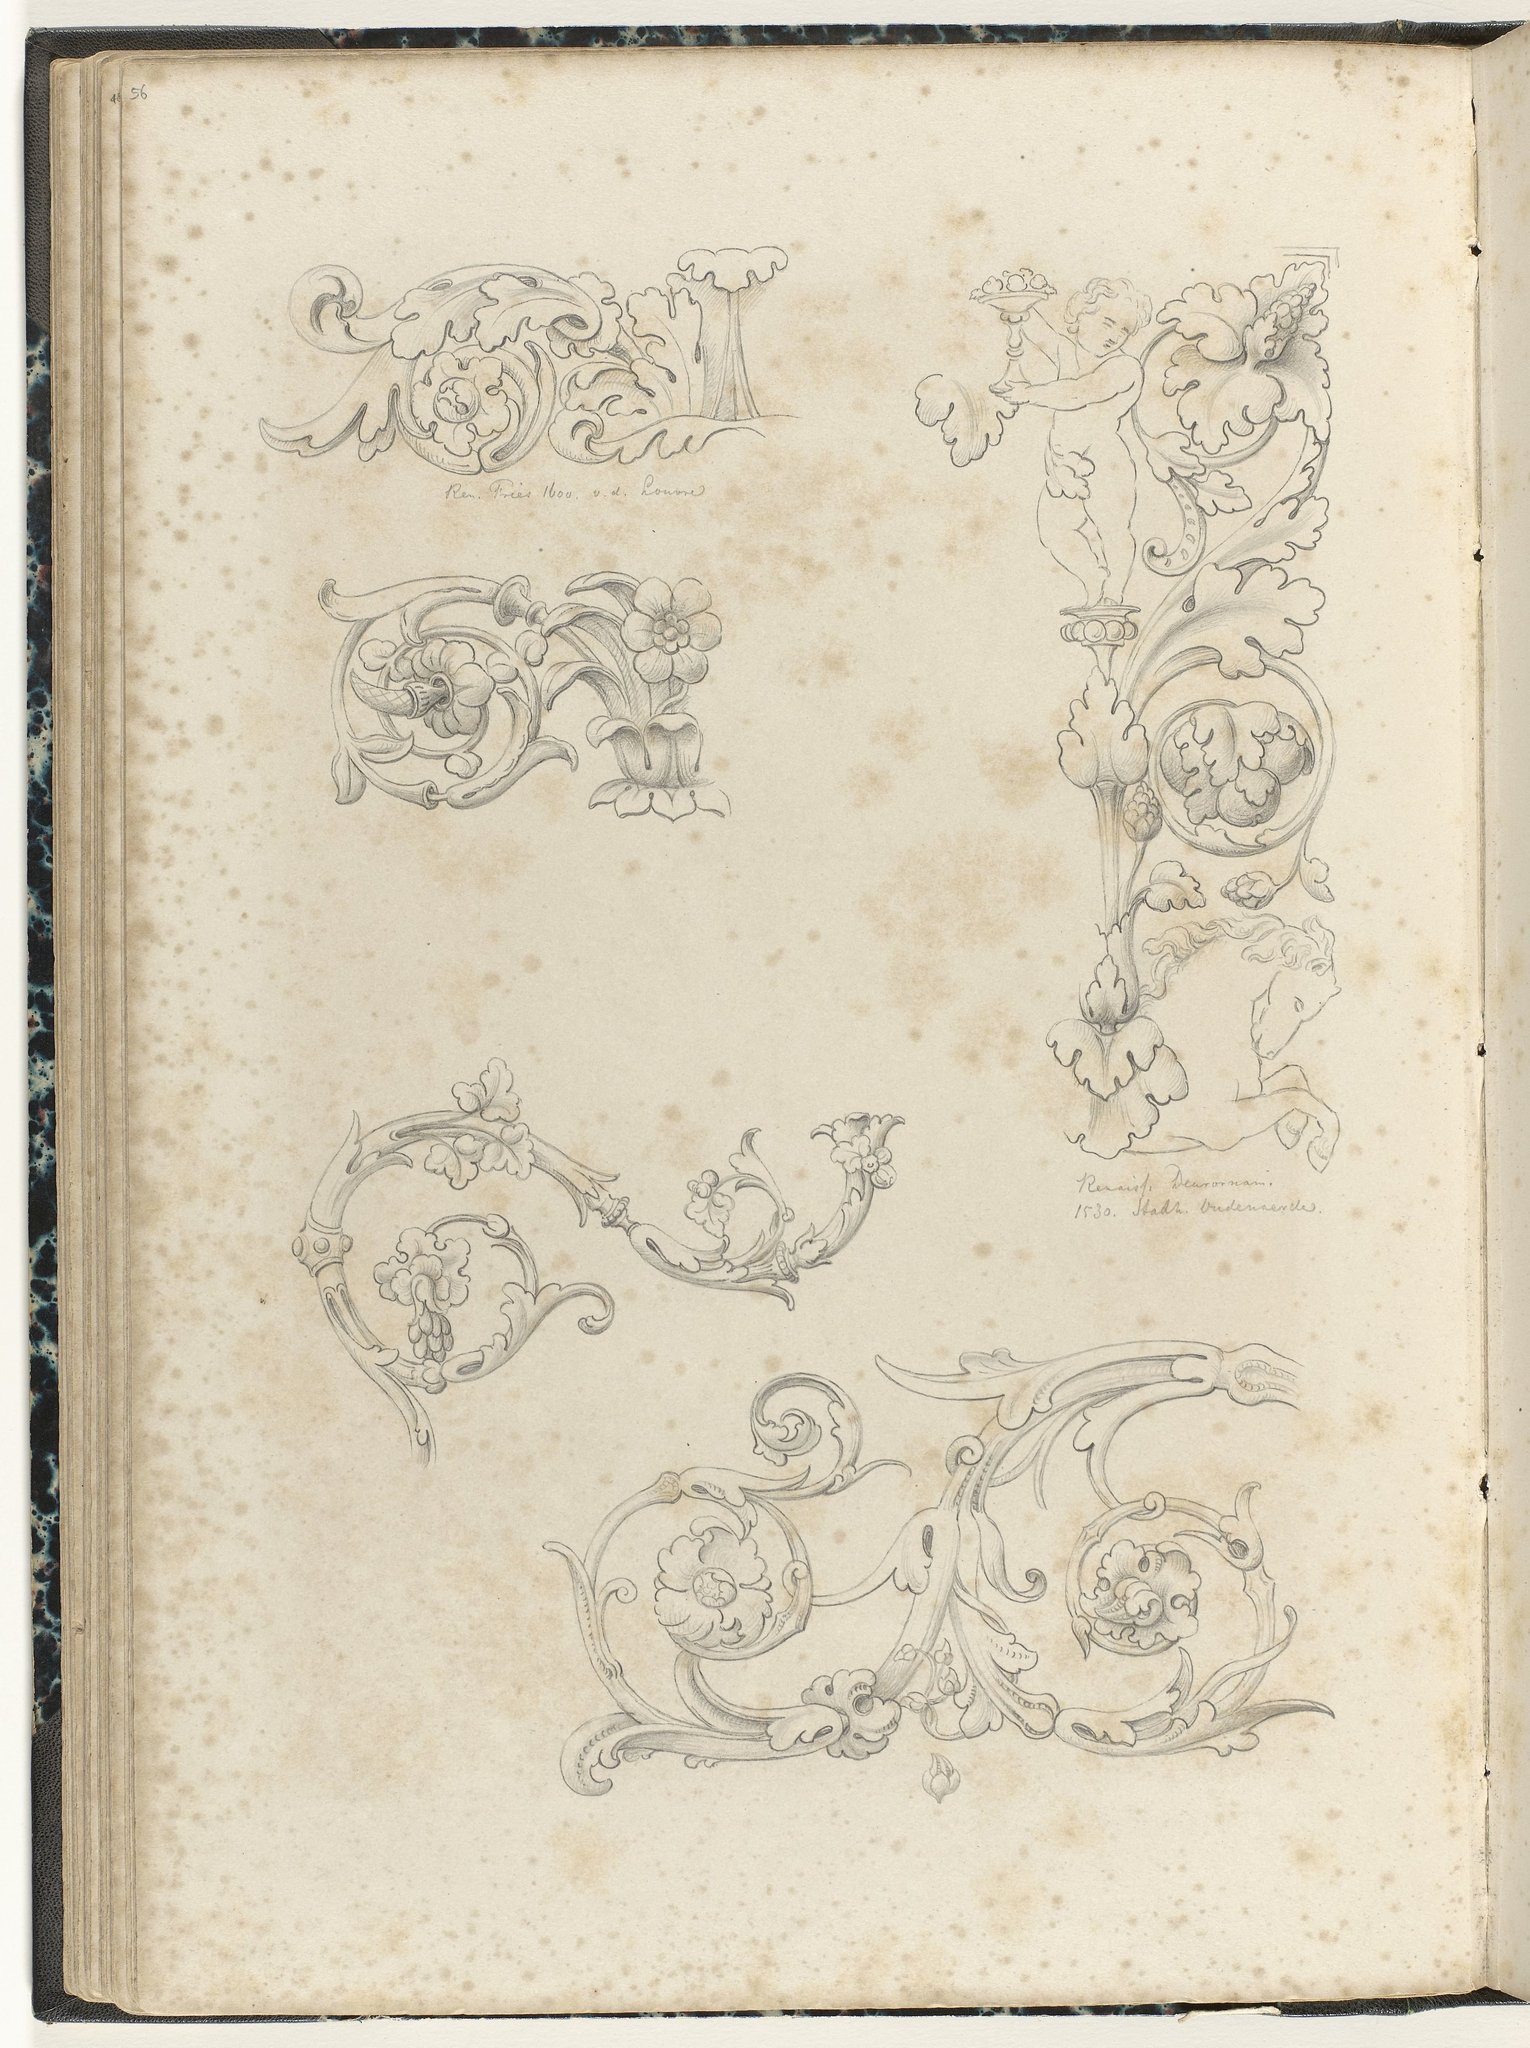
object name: drawing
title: Vijf ornamenten met bladranken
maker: Anonymous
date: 1866-1900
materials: paper, pencil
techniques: drawing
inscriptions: annotation: ‘Renaiss. Deurornam. 1530. Stadh. Oudenaerde.’, annotation: ‘Ren. Fries 1600, v.d. Louvre’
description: Rechtsboven staat een kind op een voetstuk afkomstig uit bladranken. De ornamenten zijn voor de helft afgebeeld.